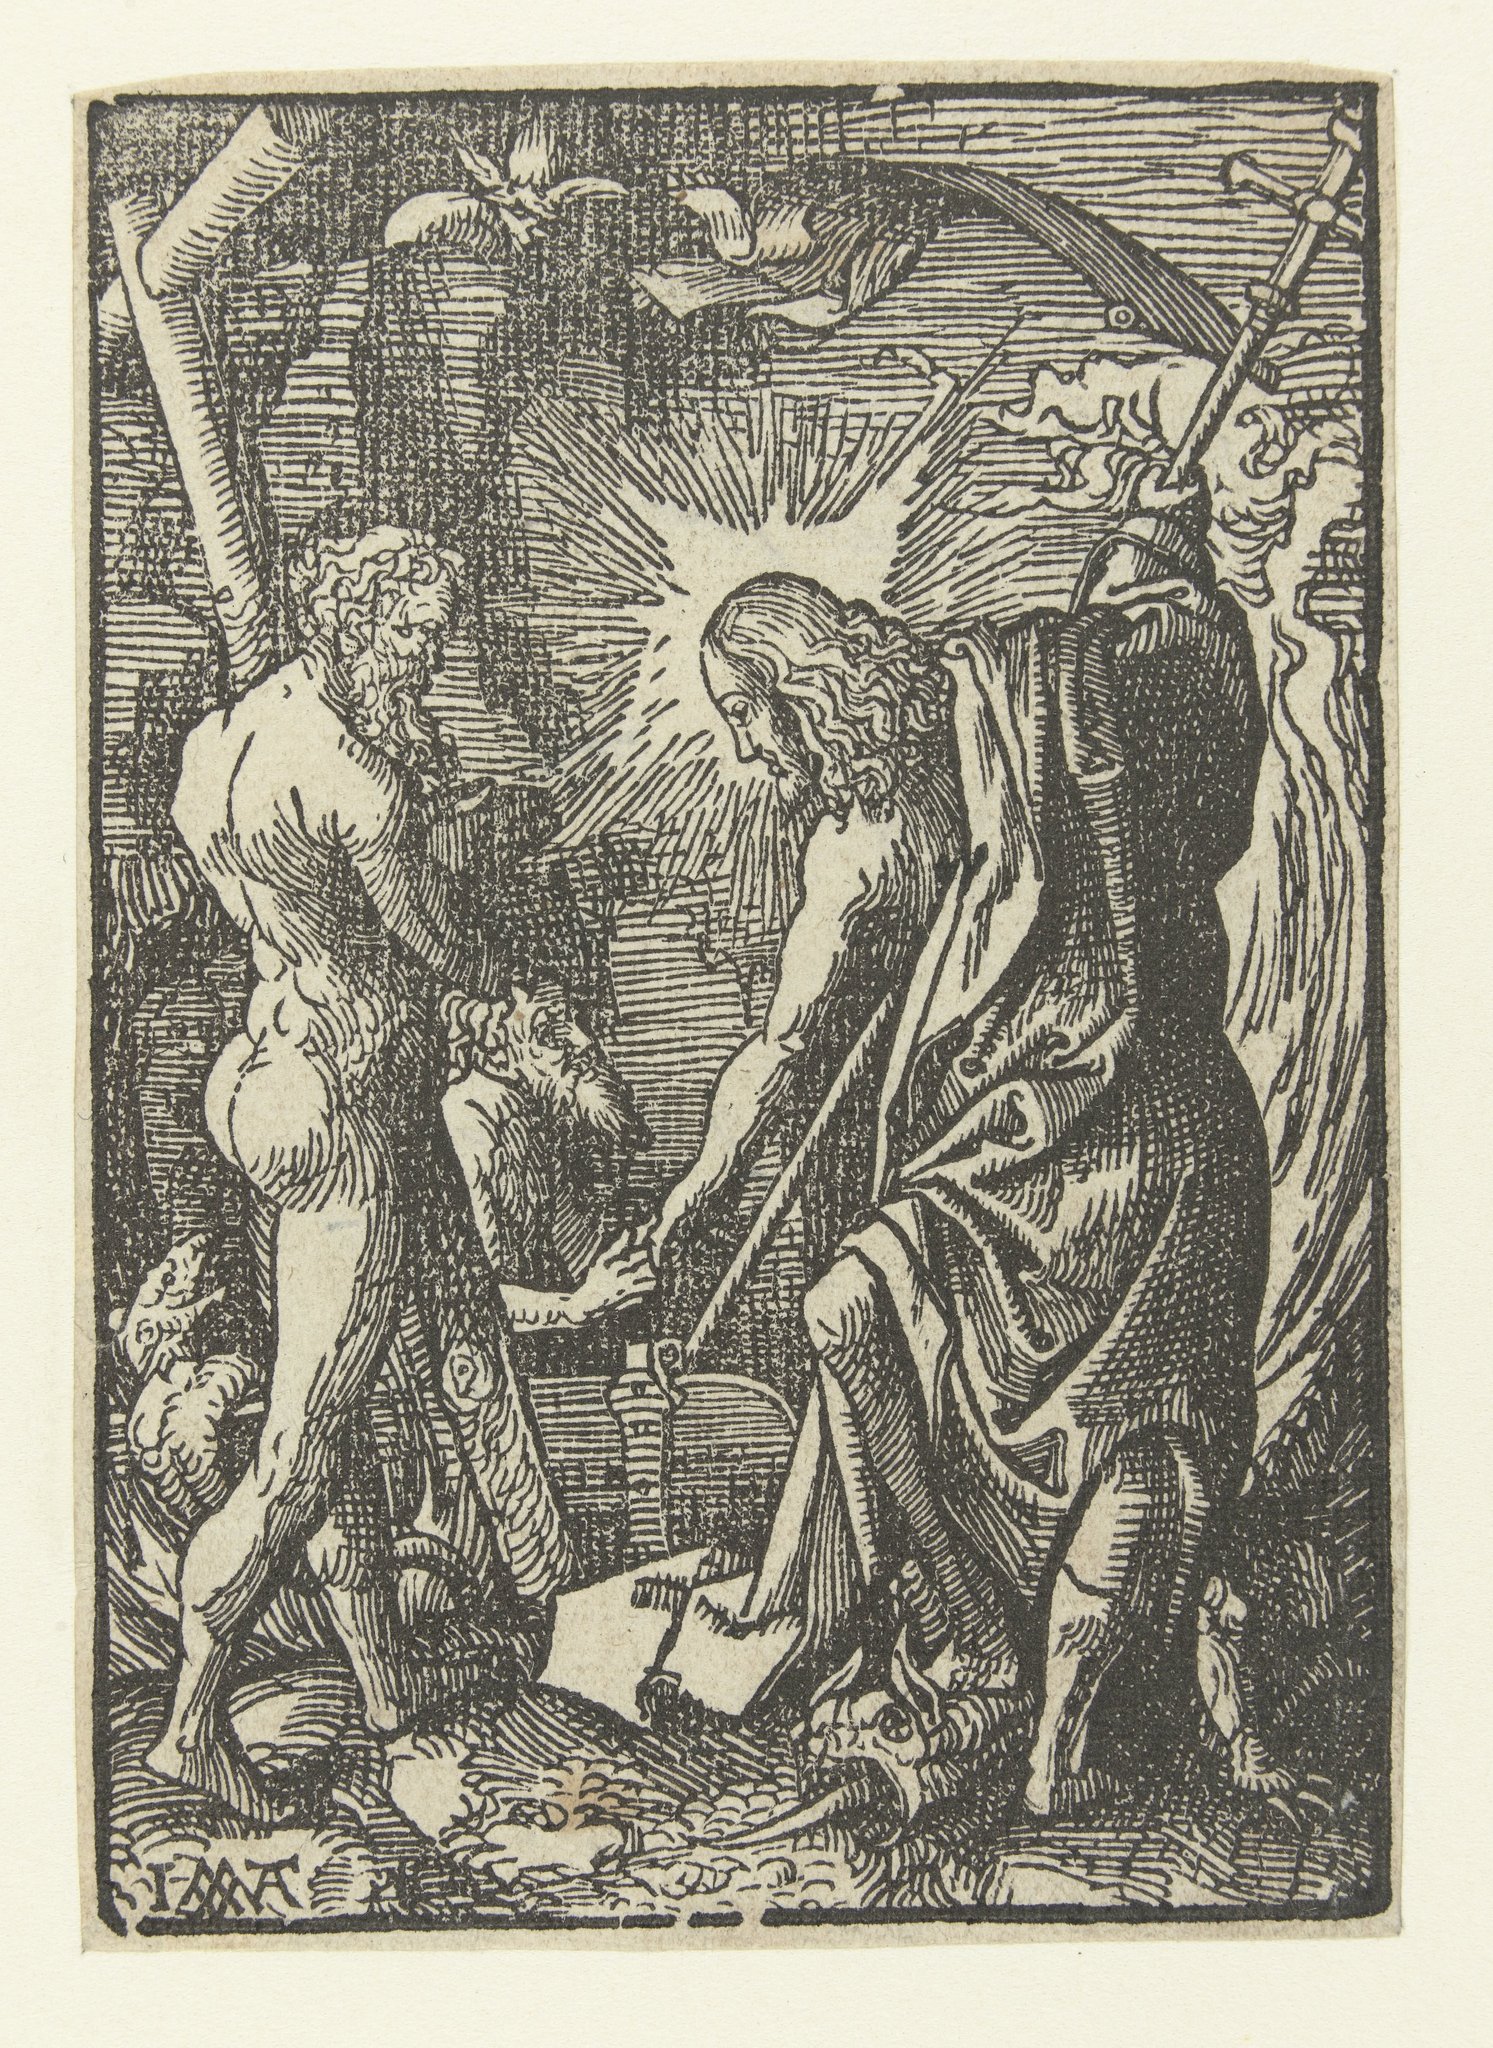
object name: print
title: De Kleine Passie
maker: jacob cornelisz van oostsanen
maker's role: draughtsman, painter, print maker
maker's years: 1475-1533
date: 1520-1521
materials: paper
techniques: woodcut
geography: low countries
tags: christ arrives at the entrance of hell and breaks the door(s)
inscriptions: collector's mark: Lugt 240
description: Uit serie van 66 prenten. Proefdruk, geen tekst op verso.